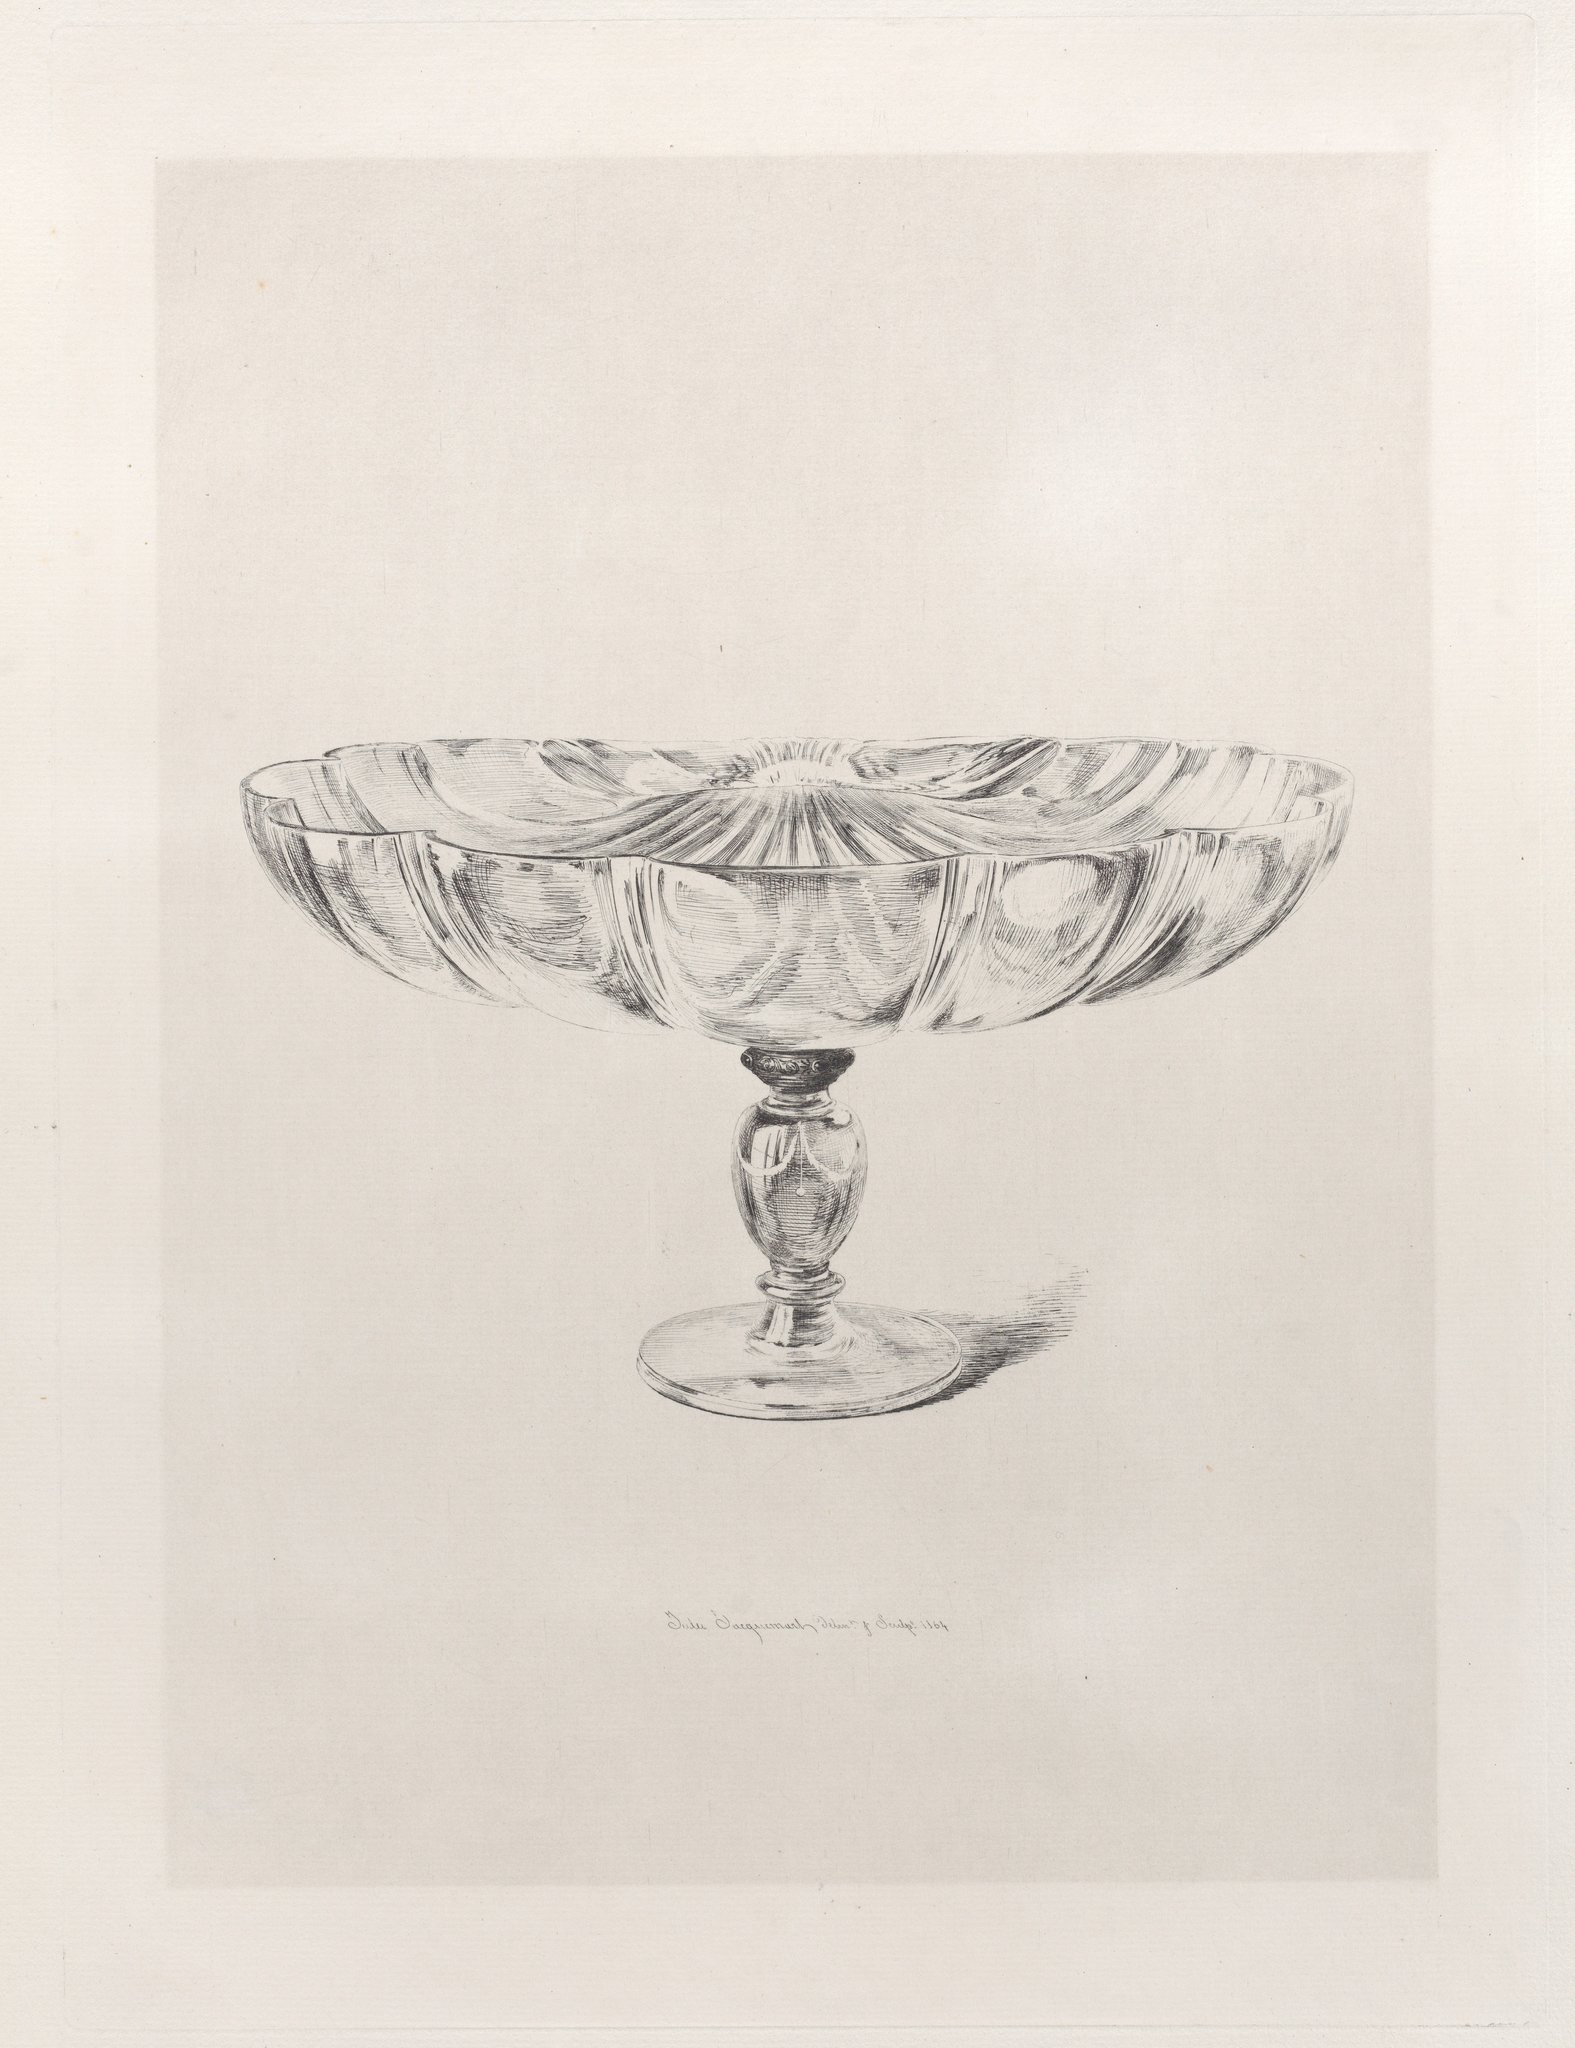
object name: print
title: Crystal Bezel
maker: jules-ferdinand jacquemart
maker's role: artist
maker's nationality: french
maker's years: 1837-1880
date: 1864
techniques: etching